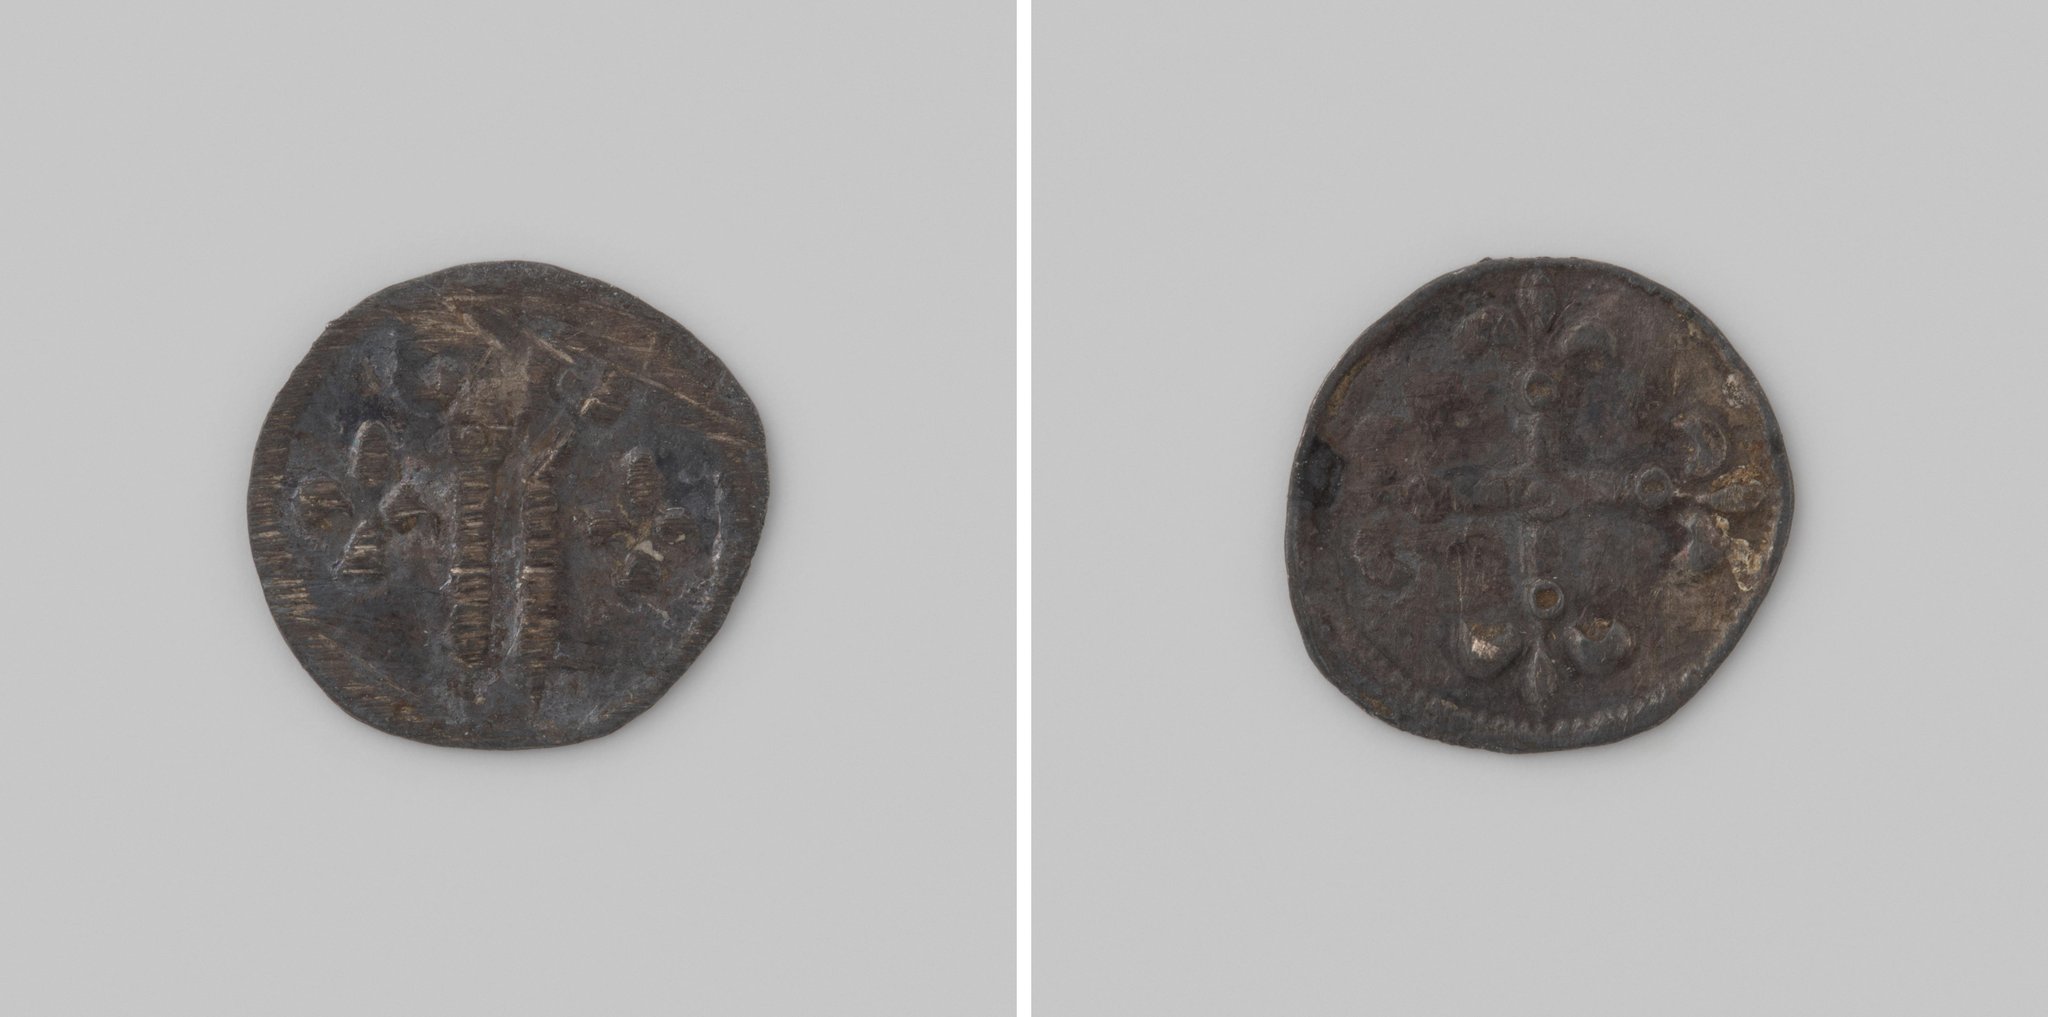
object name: obool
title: Obool (kleine penning) uit de abdij van Middelburg.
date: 1200-1250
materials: silver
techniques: striking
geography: middelburg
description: Zilveren munt. Voorzijde: twee staven, aan weerzijden daarvan een lelie. Keerzijde: gebloemd kruis.